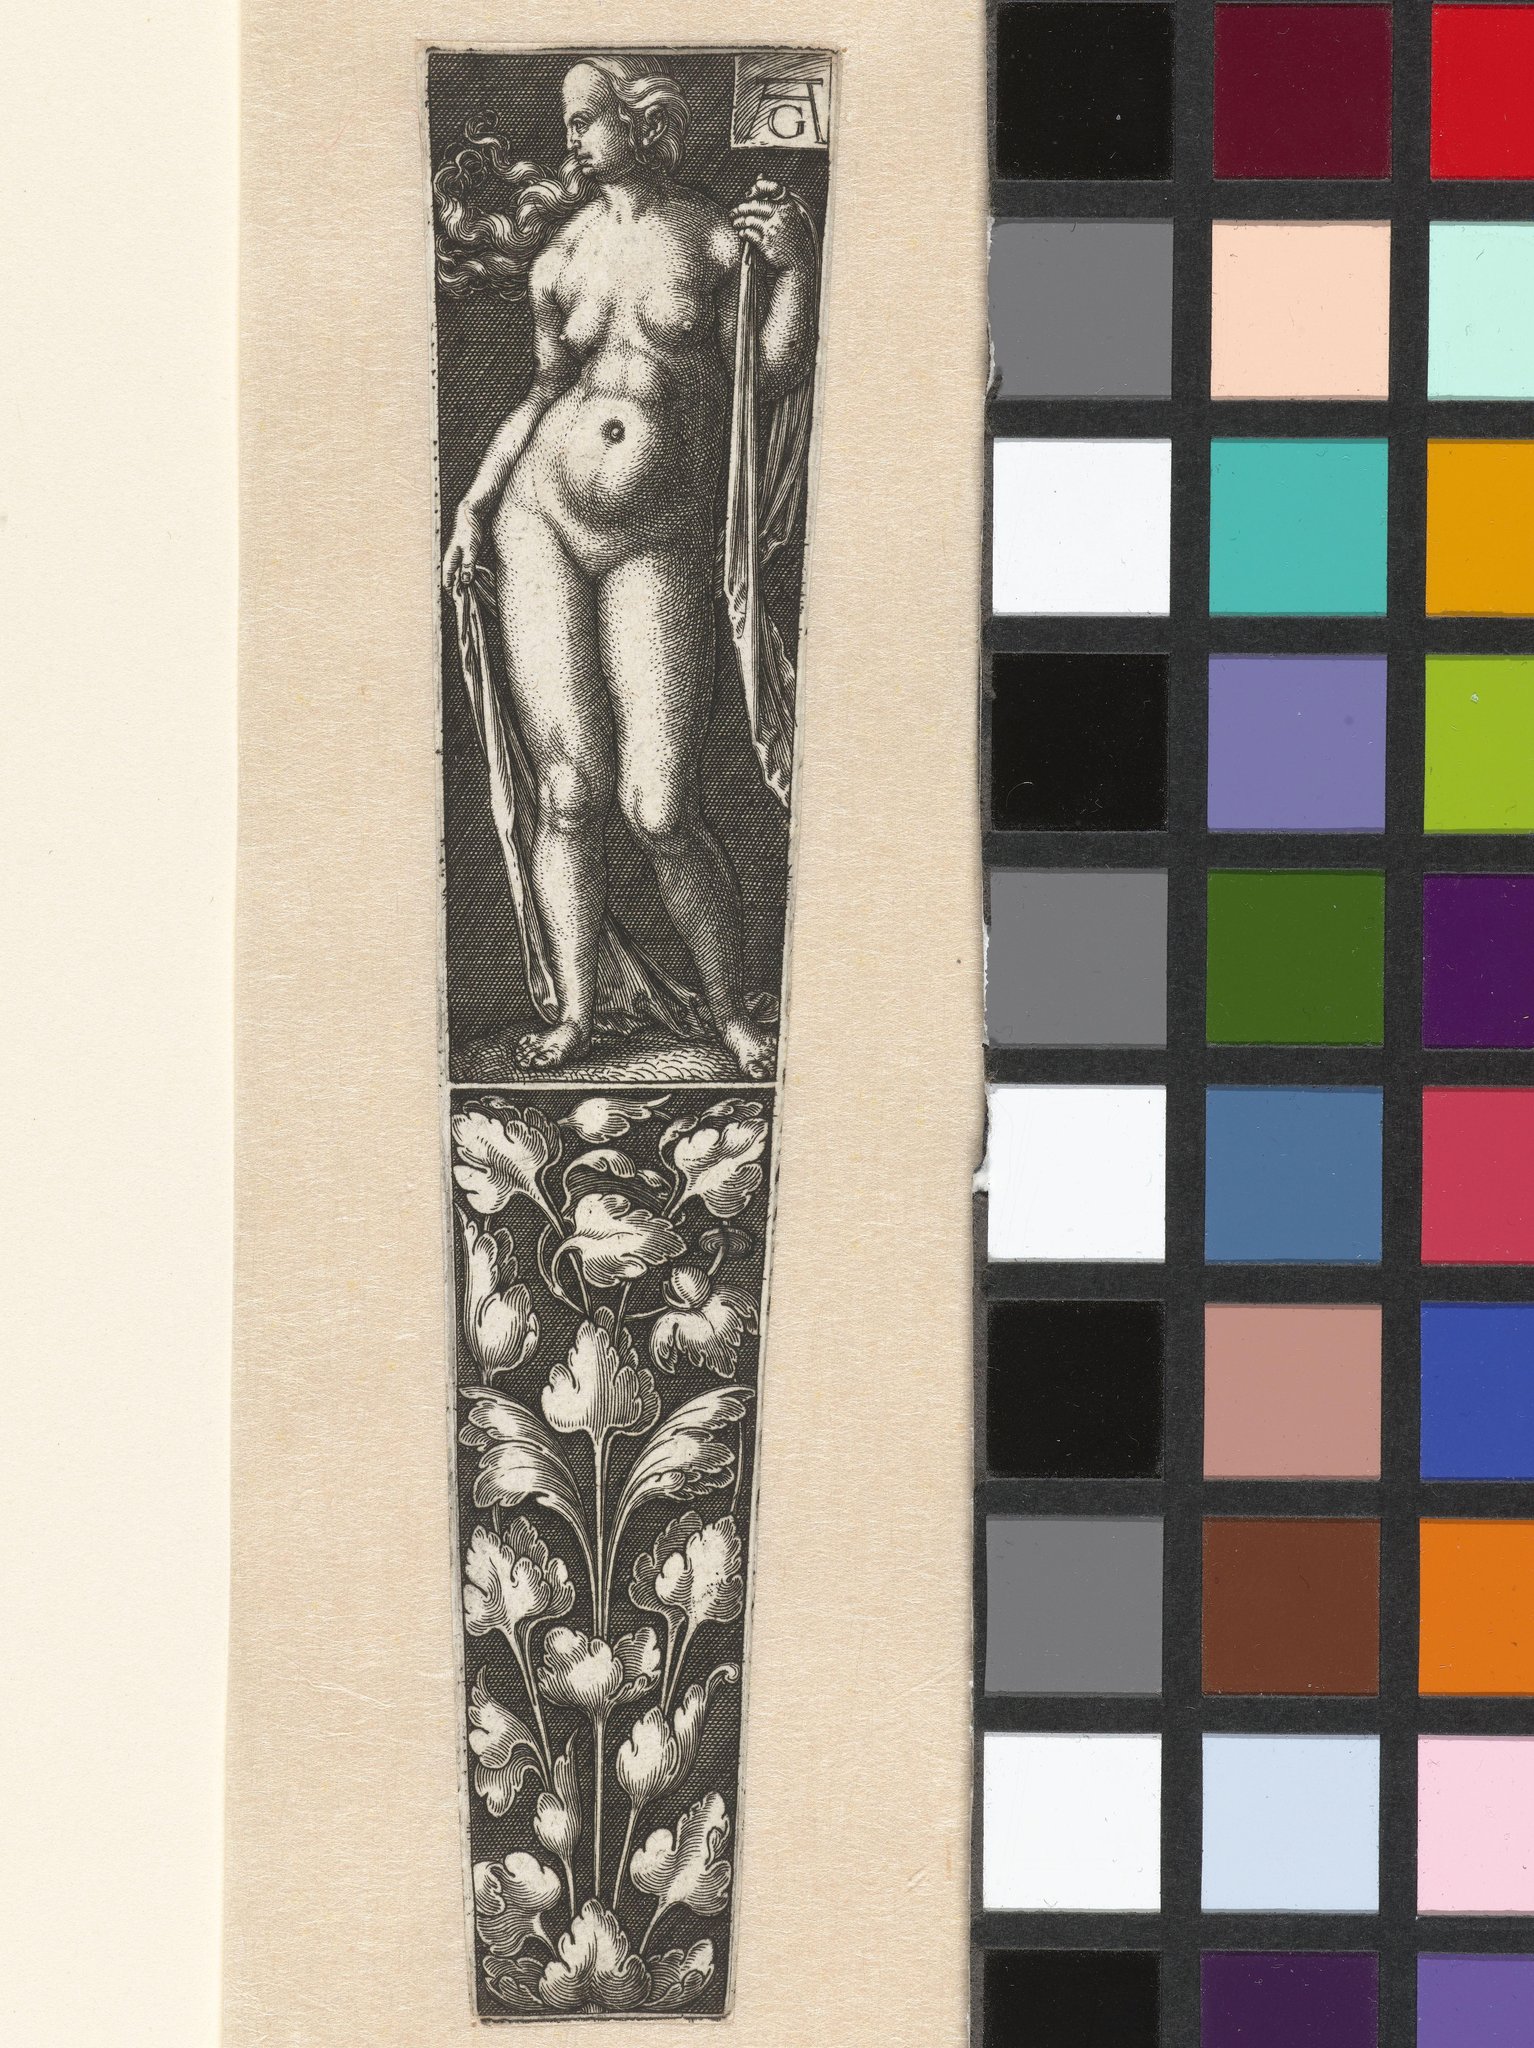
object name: print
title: Ornament met een naakte vrouw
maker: heinrich aldegrever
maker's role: draughtsman, print maker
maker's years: 1502-1561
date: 1512-1560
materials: paper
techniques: engraving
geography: germany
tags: ornaments ~ art, scabbard, sheath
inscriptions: number: ‘34’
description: Ontwerp voor een dolkschede. Het onderste deel is gedecoreerd met bladranken, daarboven staat een naakte vrouw.